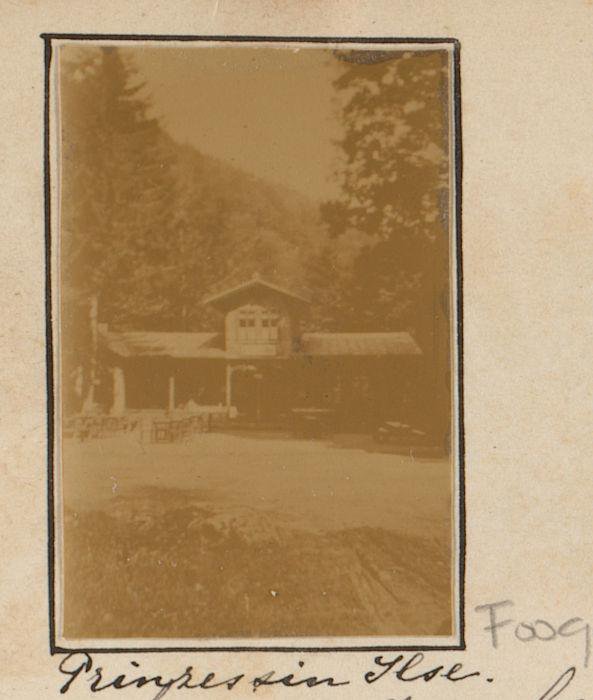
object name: photograph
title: Gezicht op een gebouw te Prinzessin Ilse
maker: Anonymous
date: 1885-1891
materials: photographic support, plant material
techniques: albumen print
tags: trees, civic architecture; edifices; dwellings, mountains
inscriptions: annotation: ‘kering der [...]heden, zee/ moeilijk te vinden zijn te/ (...)’, annotation: ‘Prinzessin Ilse’